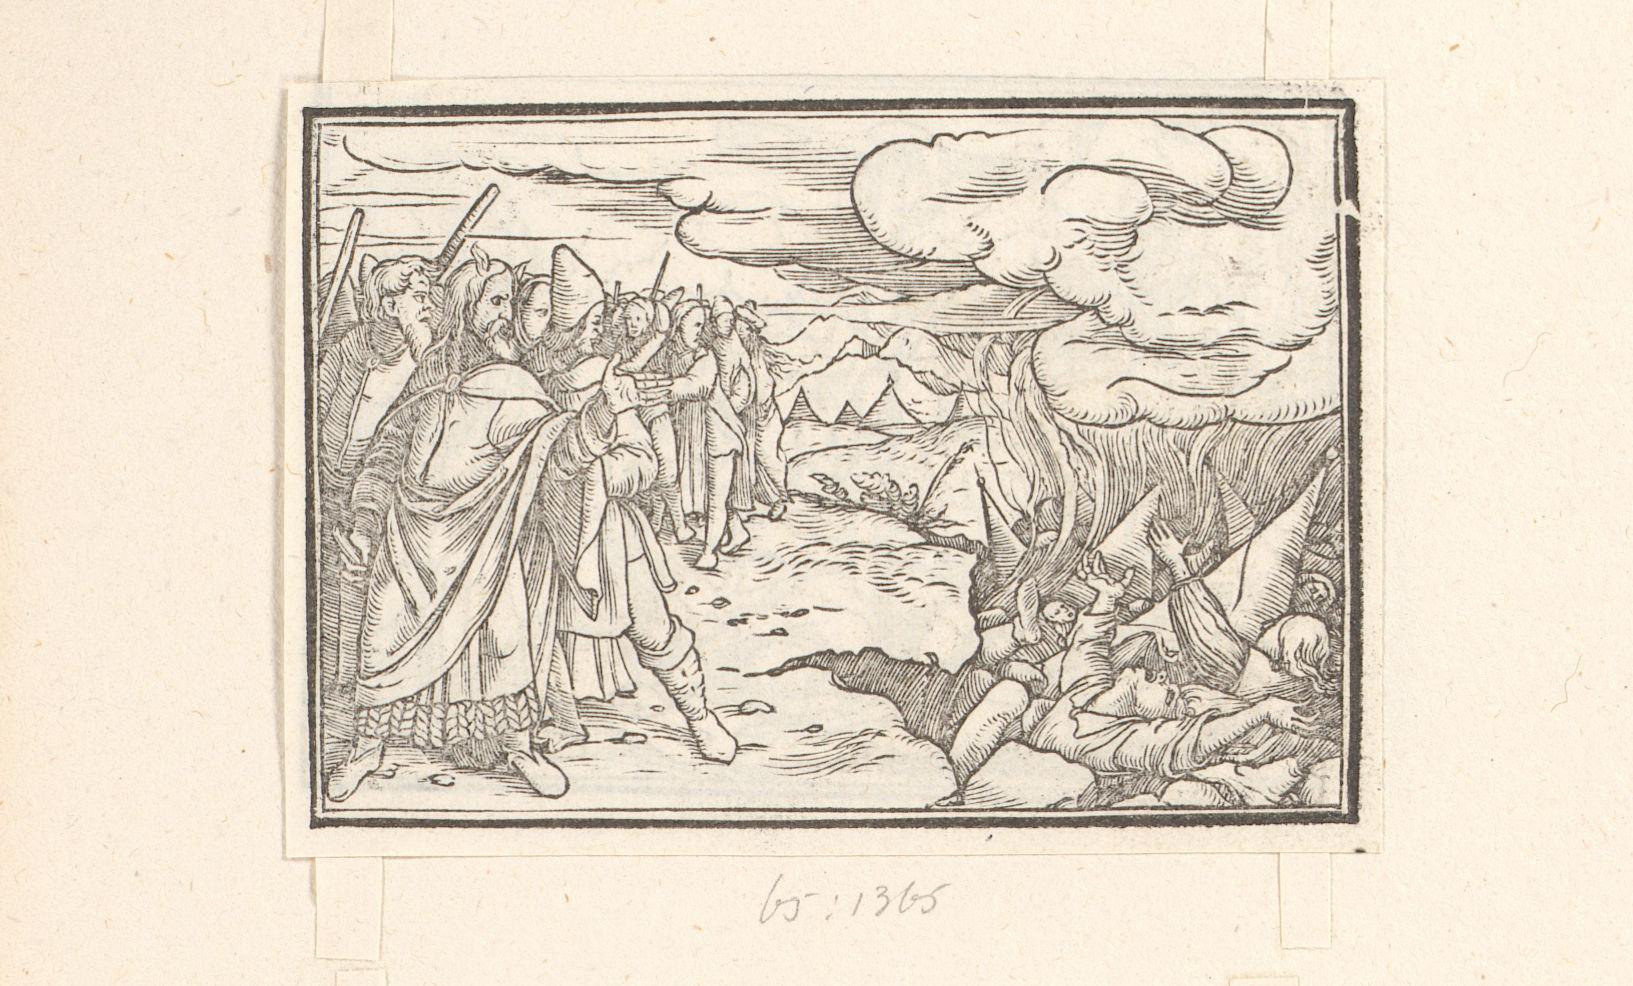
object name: album leaf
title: Vernietiging van de stam van Korach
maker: veit rudolf specklin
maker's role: print maker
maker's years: -1550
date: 1538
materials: paper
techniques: woodcut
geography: switzerland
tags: rebellion of korah (core), dathan and abiram, and their punishment (numbers 16)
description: Boekillustratie voor het eerst gebruikt in: Biblia Utriusque Testamenti iuxta Vulgatam Translationem, Lyon, M. en G. Trechsel (voor Hugo à Porta) 1538. Later in verschillende uitgaven opnieuw gebruikt. Deze prent vermoedelijk gebruikt in één van de uitgaven uitgegeven en/of gedrukt door Jean Frellon, Lyon.